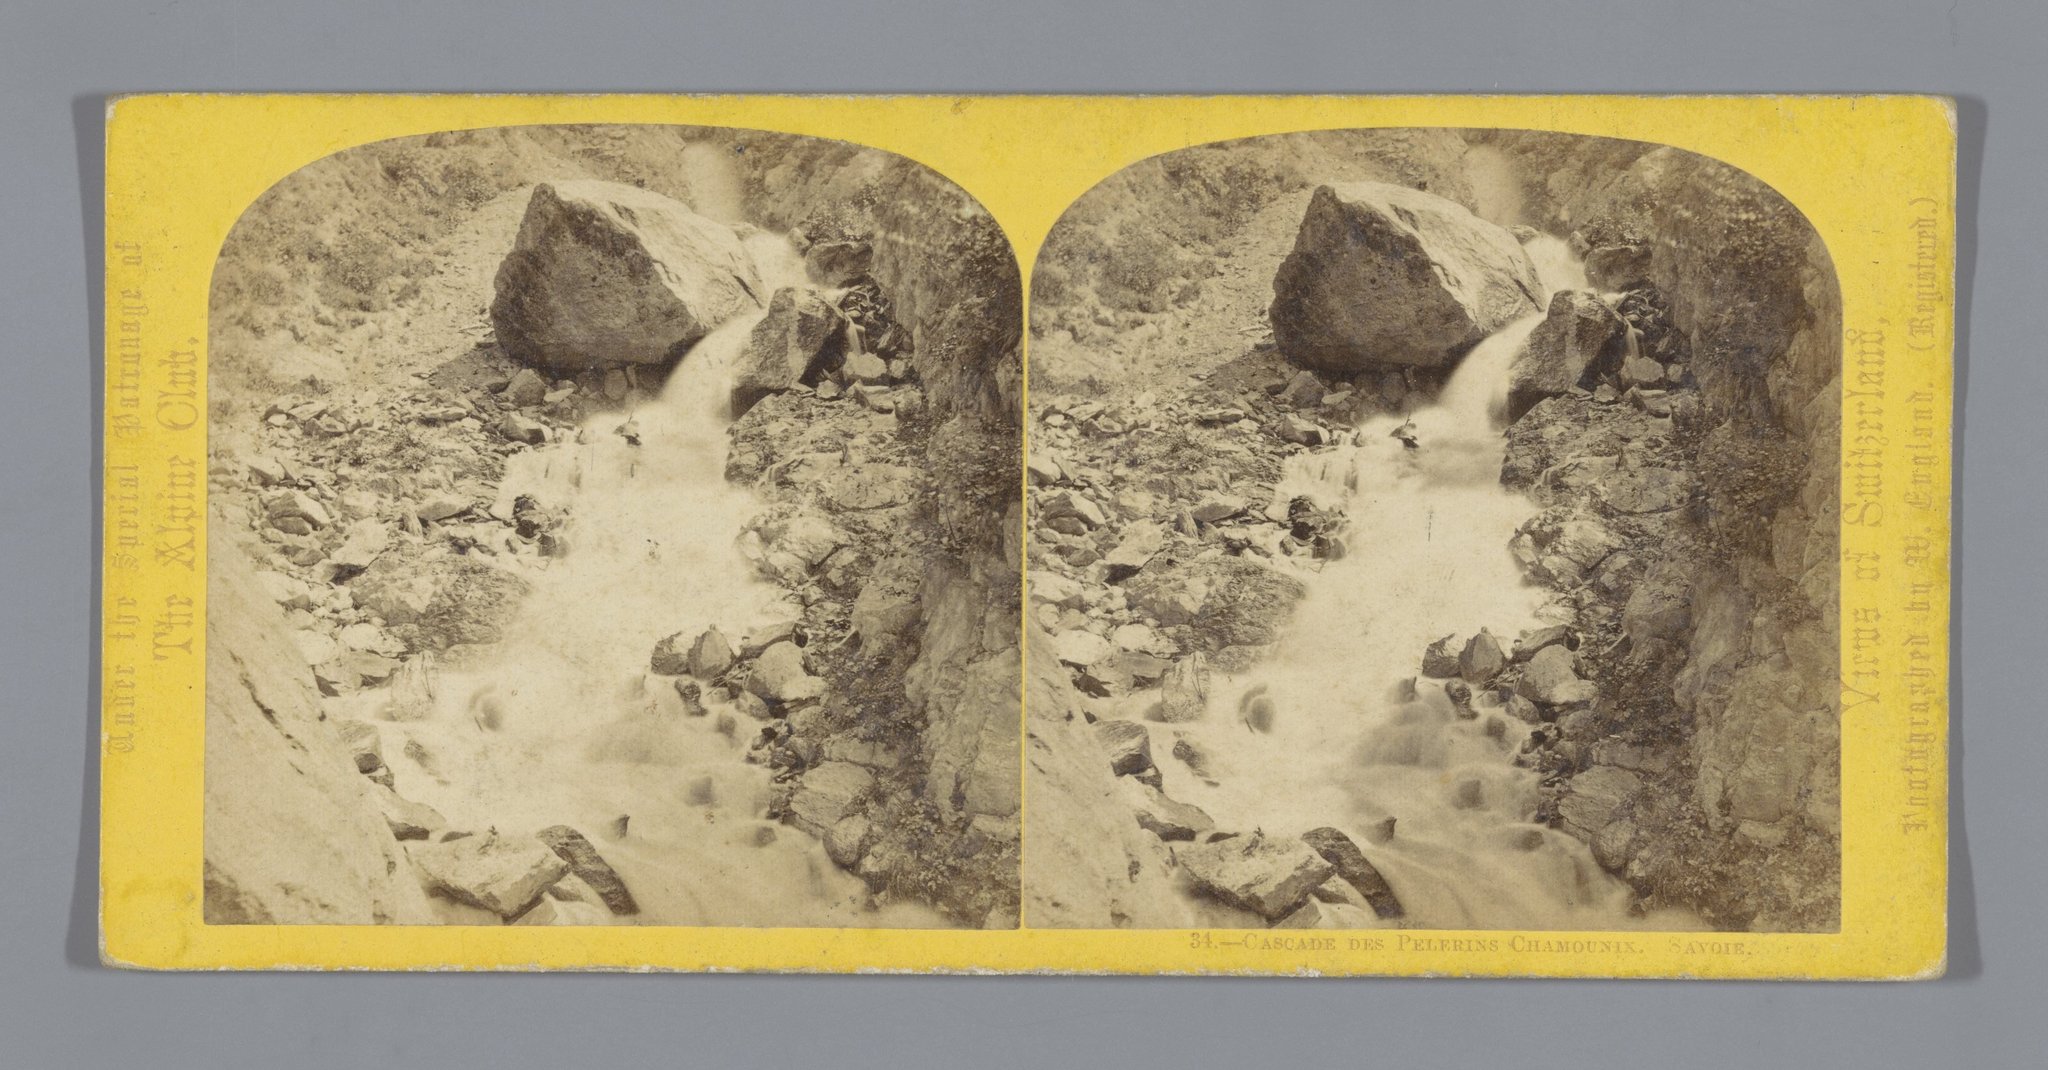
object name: stereograph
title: Cascade des Pelerins Chamounix. Savoie.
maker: william england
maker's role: fotograaf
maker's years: 1816-1896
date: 1850-1880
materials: cardboard, photographic support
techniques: albumen print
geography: bonneville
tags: waterfall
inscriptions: inscription: ‘Views of Switzerland, photographed by W. England. (Registered) Under the Special Patronage of the Alpine Club.’, number: ‘34.’, inscription: ‘DBR’